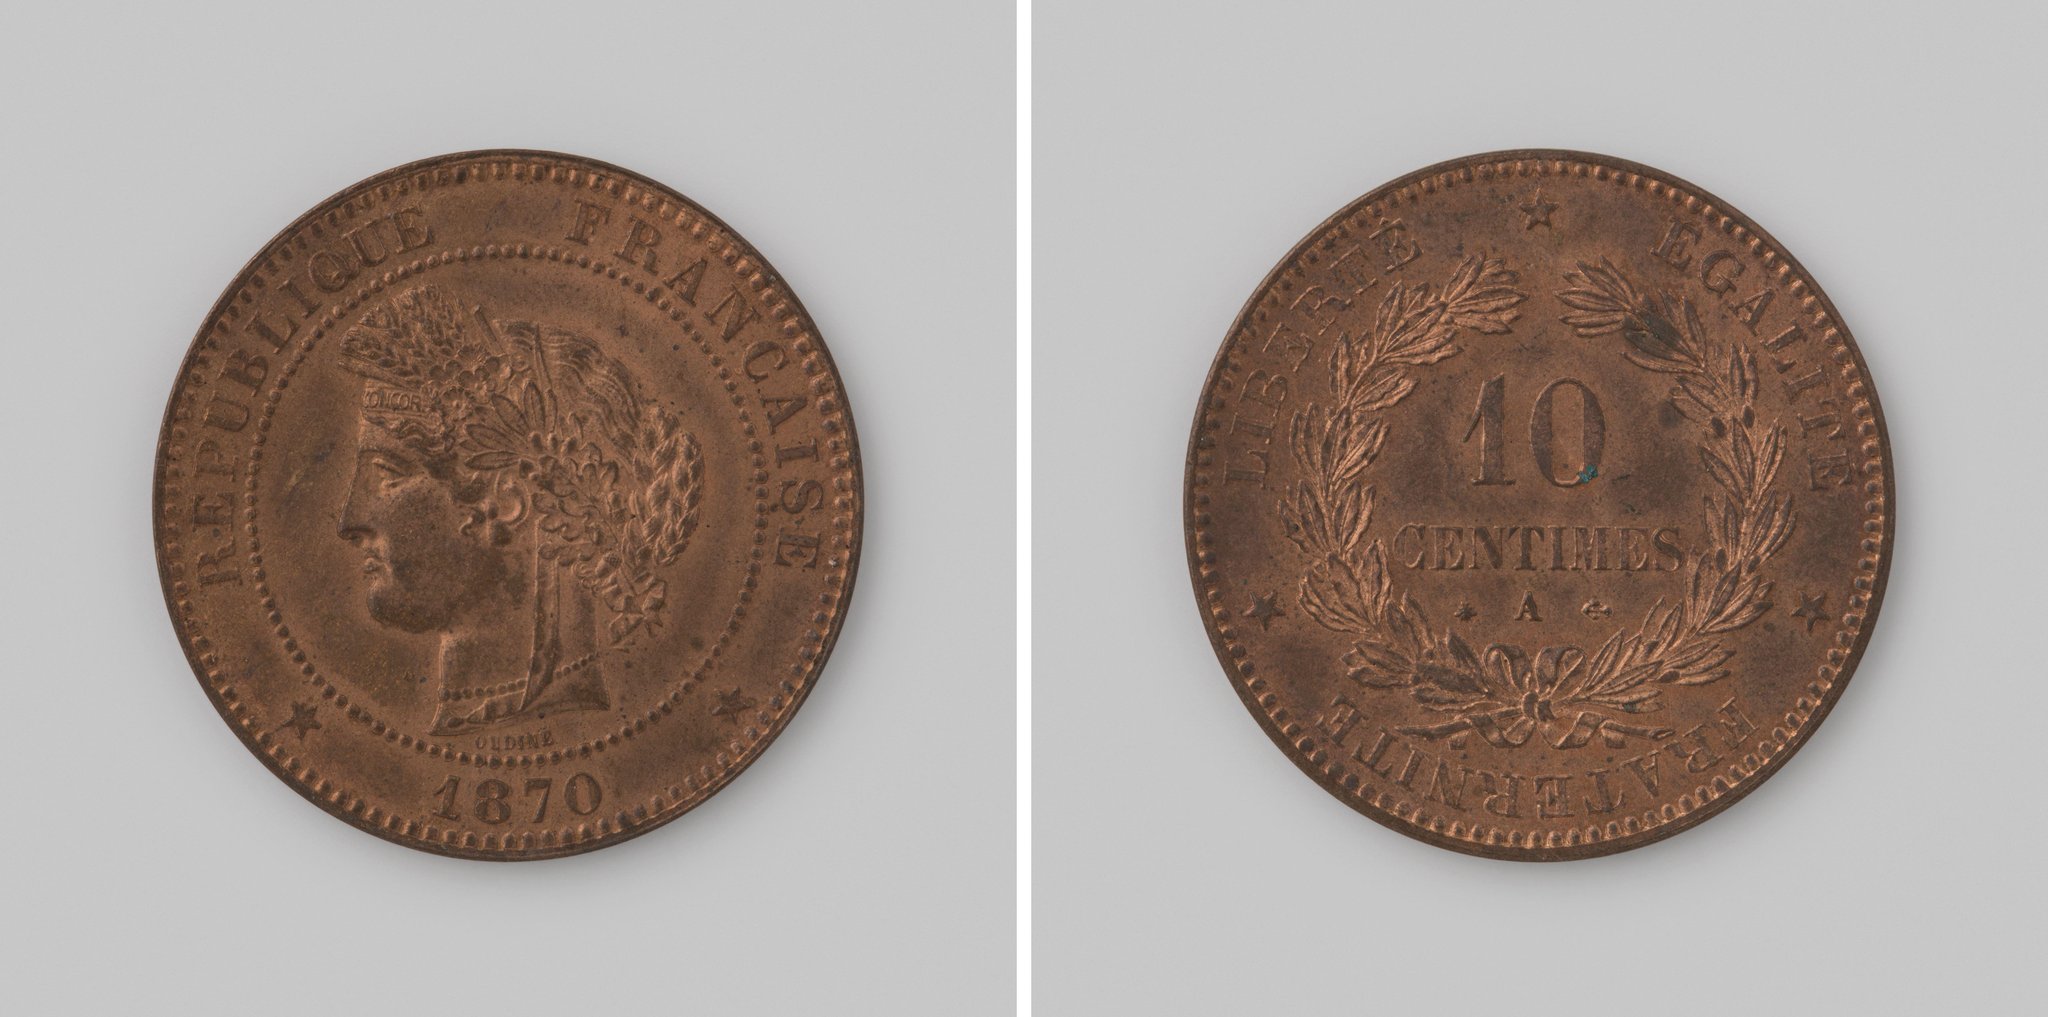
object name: coin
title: Frankrijk, Derde Republiek, 10 centimes,1870 A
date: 1870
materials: bronze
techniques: striking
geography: paris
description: Bronzen munt. Voorzijde: portret van een vrouw met krans en diadeem naar links.Jaartal onderaan. Keerzijde: binnen twee samengebonden takken waarde-aanduiding in twee regels, waaronder de letter A [=Parijs]. Gladde rand.